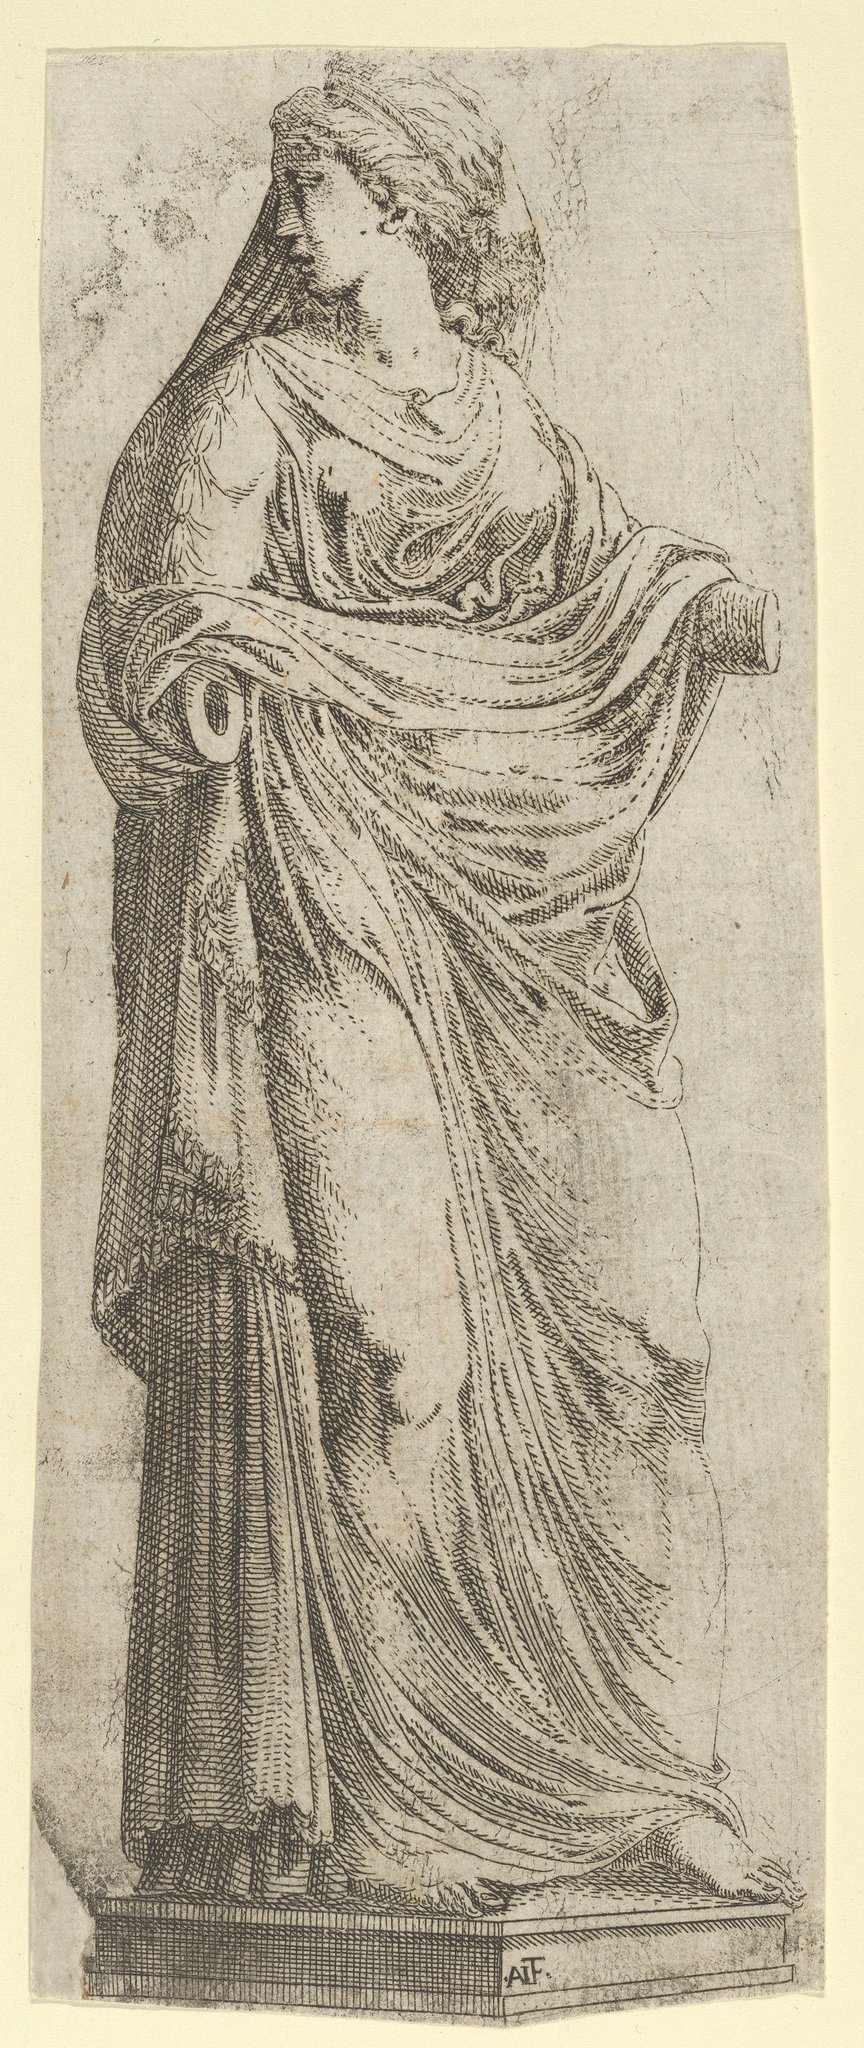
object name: print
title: Woman Looking over Her Shoulder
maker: antonio fantuzzi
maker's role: artist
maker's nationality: italian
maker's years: 1537-1545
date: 1540-1545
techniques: etching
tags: women